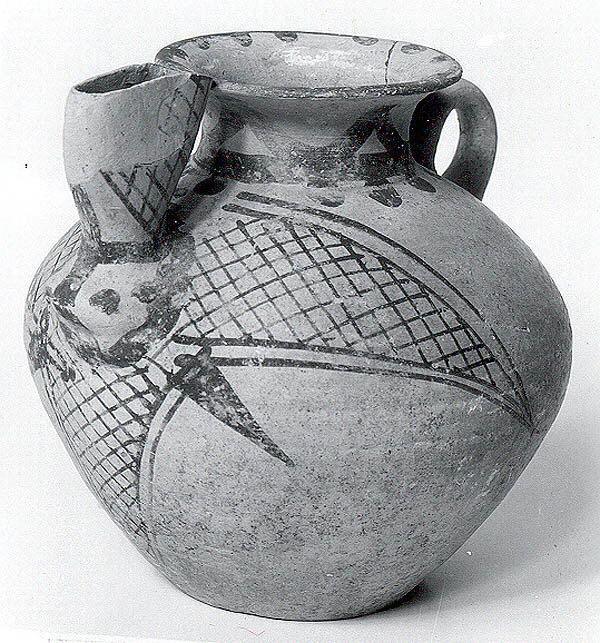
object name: jar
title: Spouted jar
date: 900-700 BCE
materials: ceramic, paint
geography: iran